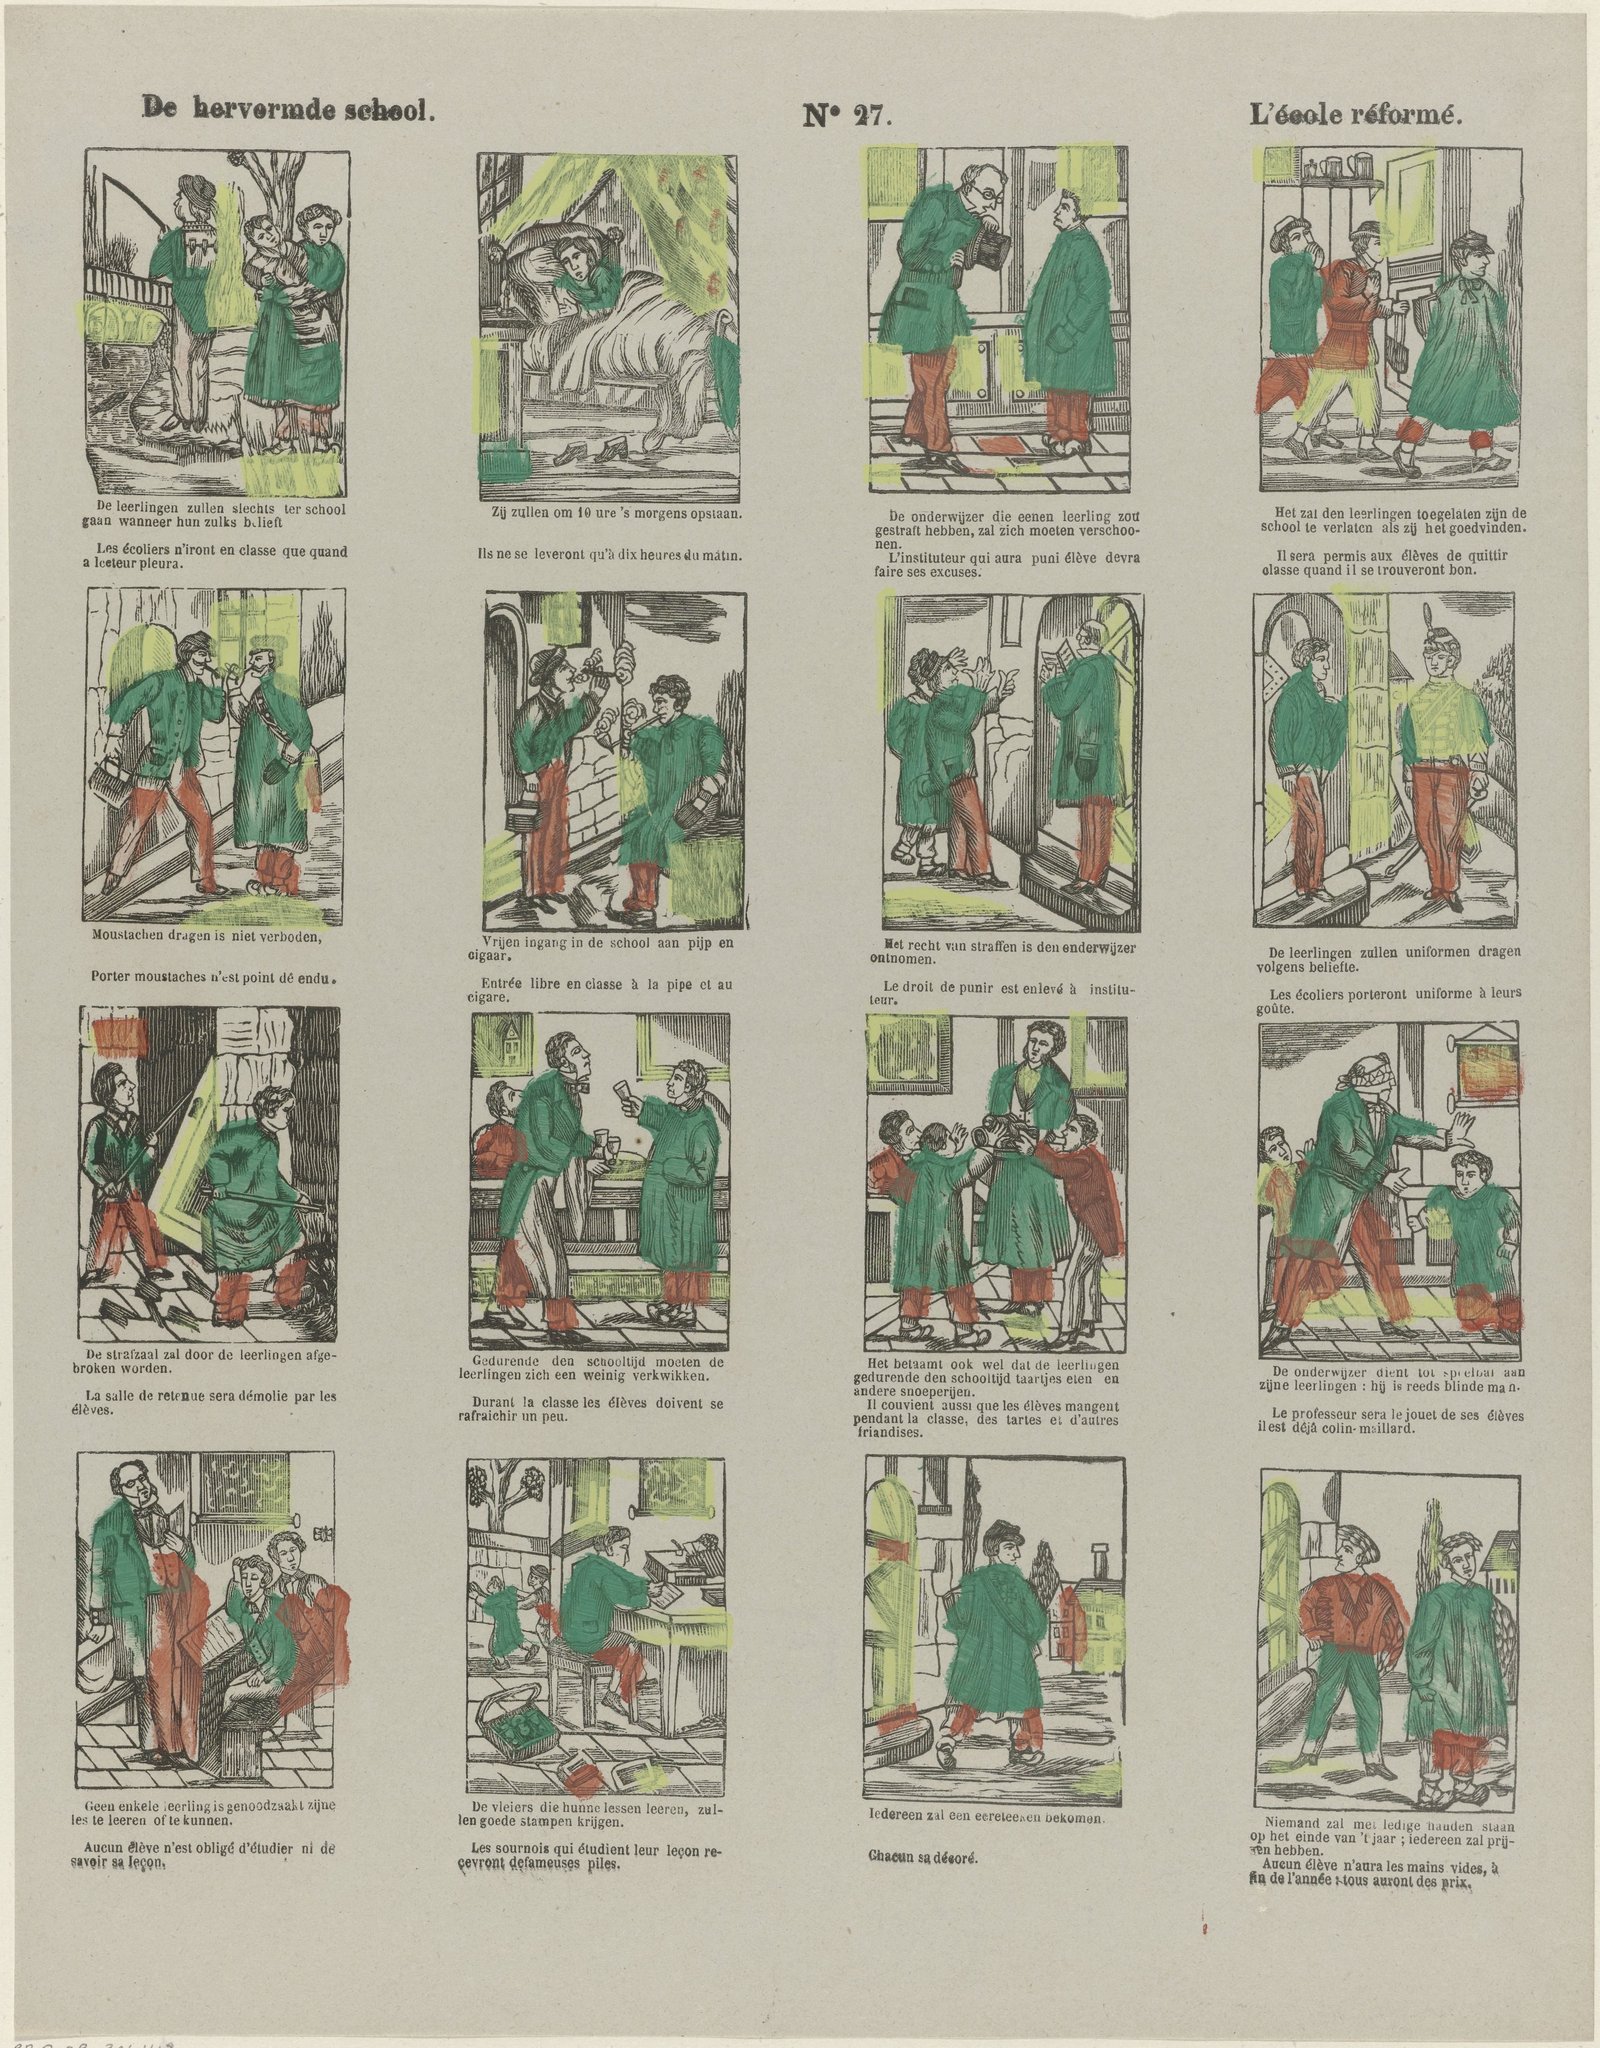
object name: print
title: De hervormde school / L'école réformée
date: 1866-1902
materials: paper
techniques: colour, letterpress printing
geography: turnhout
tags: games at school, teacher and pupil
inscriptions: collector's mark: Lugt 2760, collector's mark: ‘Edw. Ipers / Oever 27, / Antwerpen.’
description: Blad met 16 voorstellingen van leraren en leerlingen op een hervormde school. Onder elke afbeelding een onderschrift in het Nederlands en in het Frans. Genummerd midden boven: No 27.